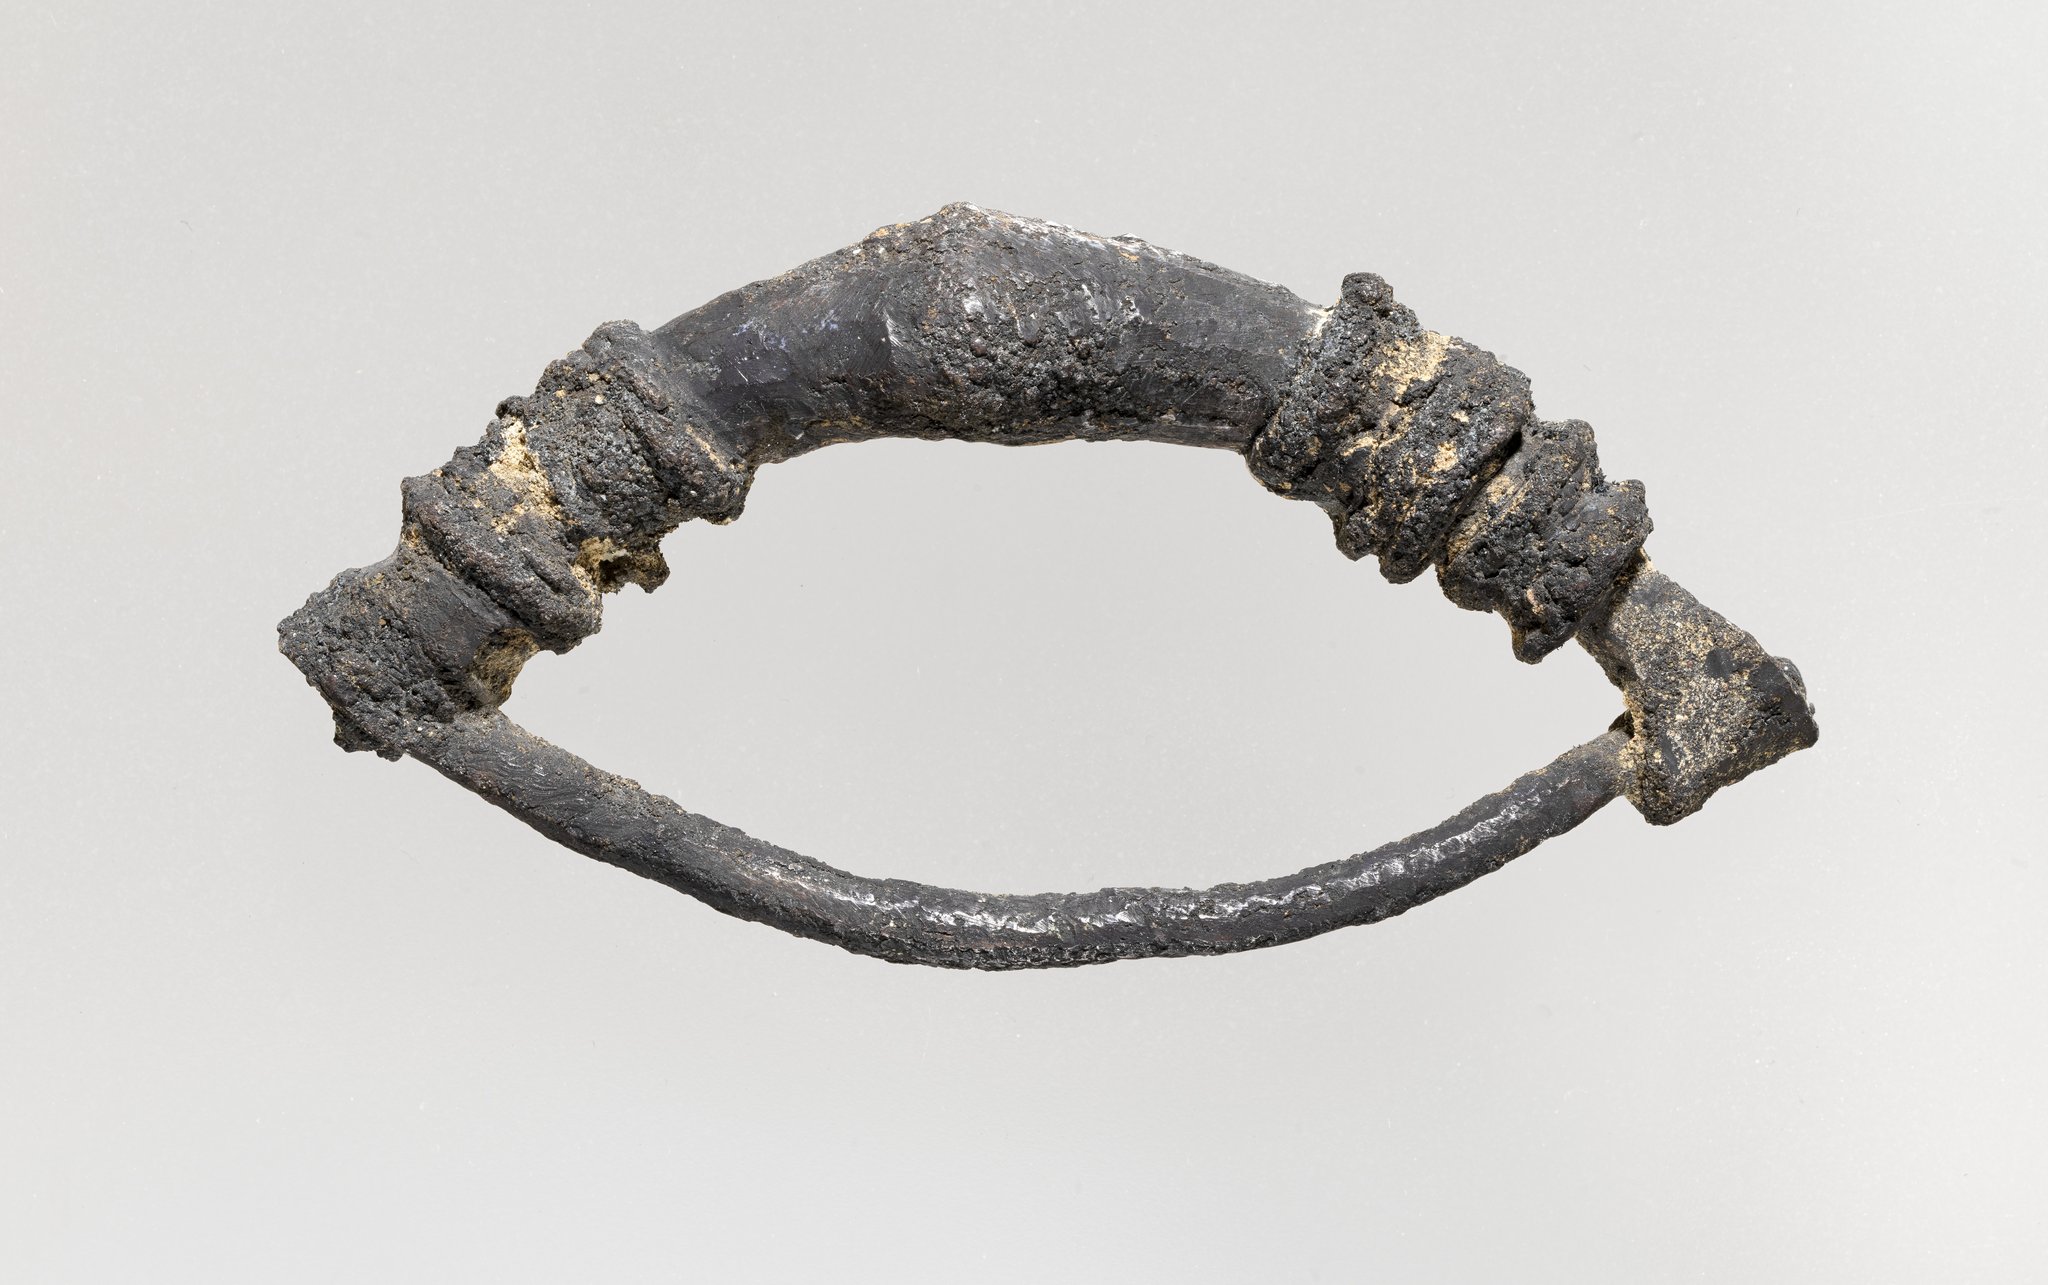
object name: fibula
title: Silver fibula (safety pin)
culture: cypriot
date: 800-701 BCE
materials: silver